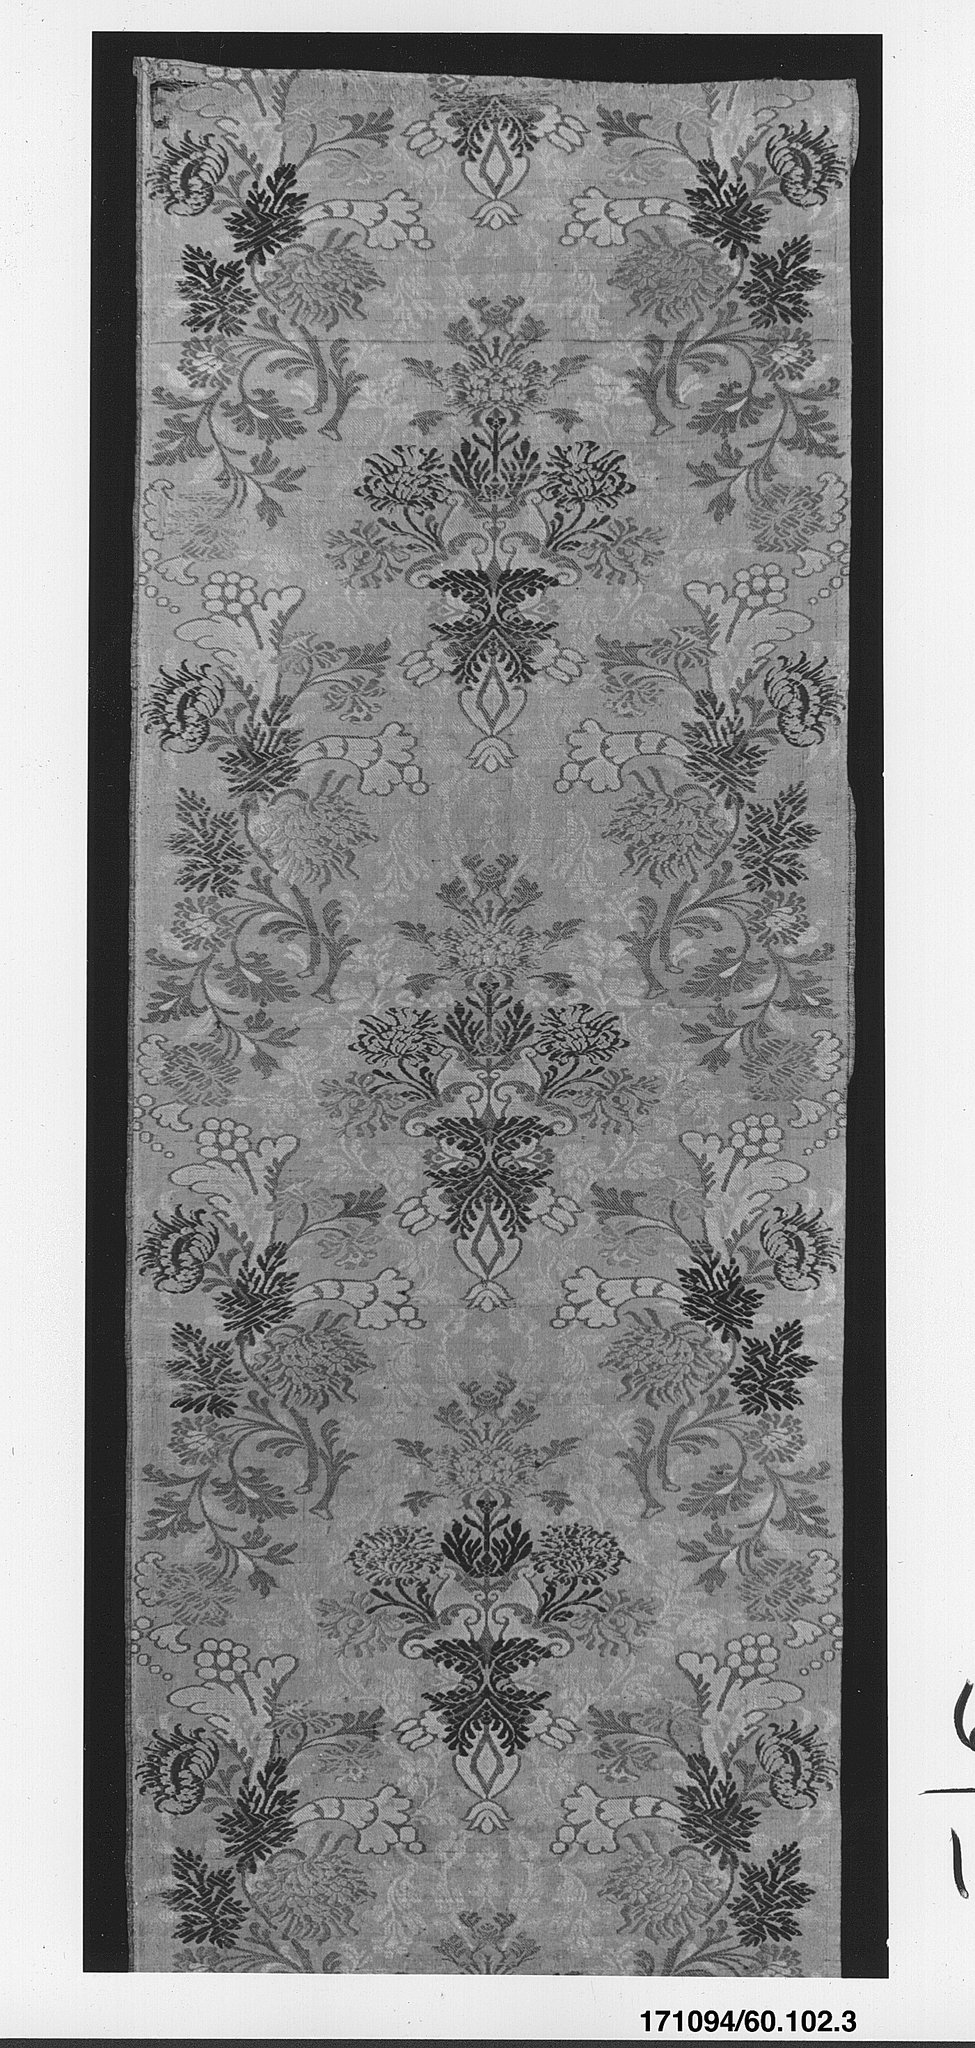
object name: piece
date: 1670-1690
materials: silk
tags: flowers,leaves